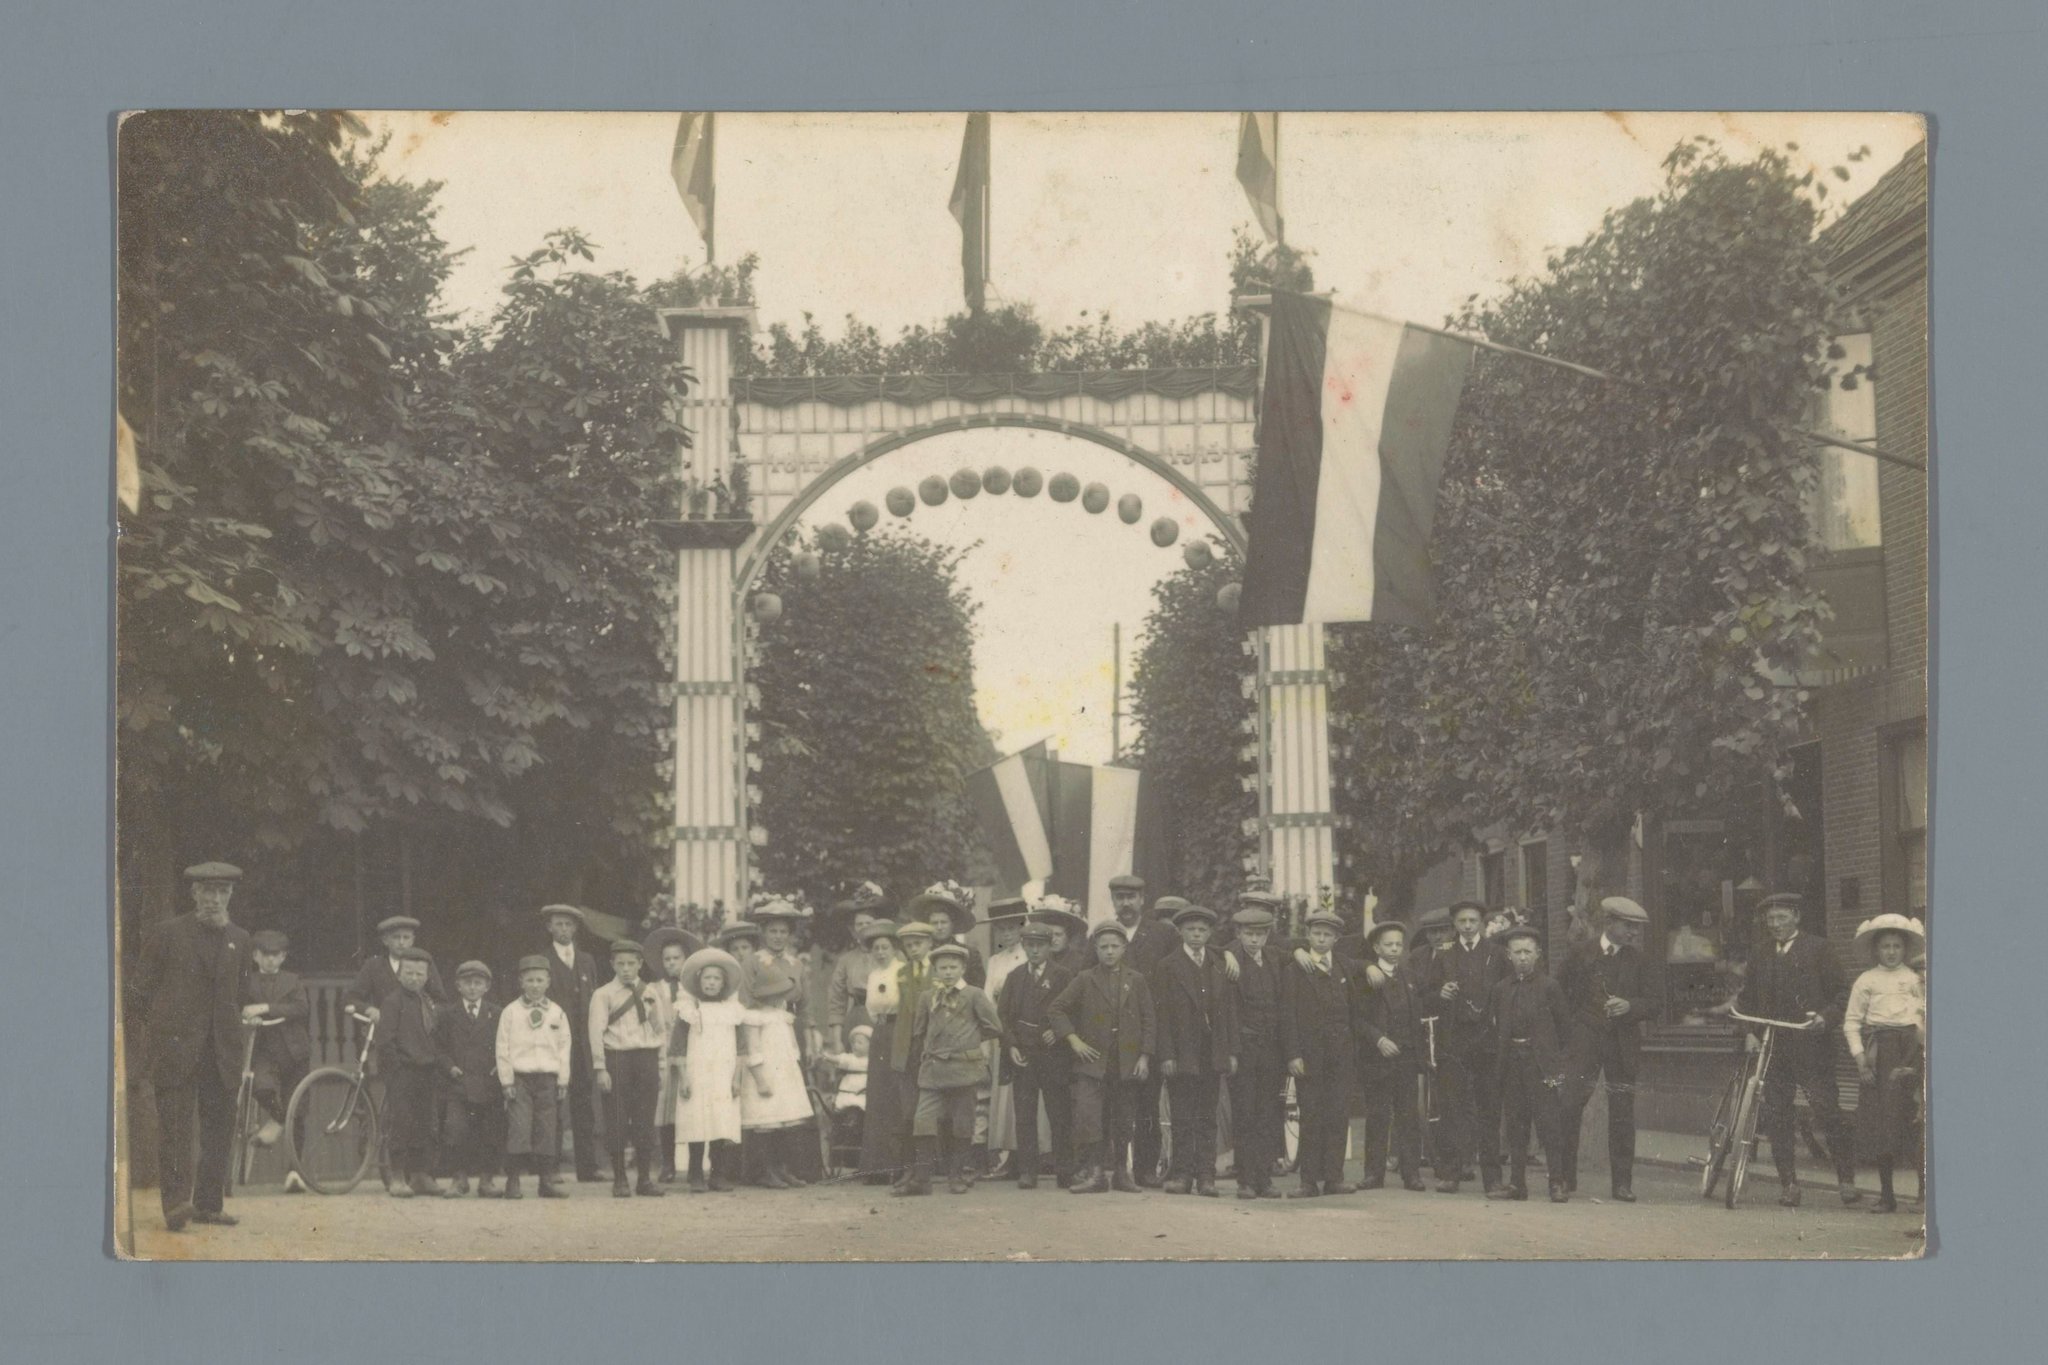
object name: photograph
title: Groepsportret van onbekende mensen in een straat met een triomfboog ter viering van de onafhankelijkheid van Nederland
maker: Anonymous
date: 1913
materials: photographic support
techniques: gelatin silver print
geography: netherlands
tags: triumphal arch, street, anonymous historical persons portrayed in a group, in a group-portrait